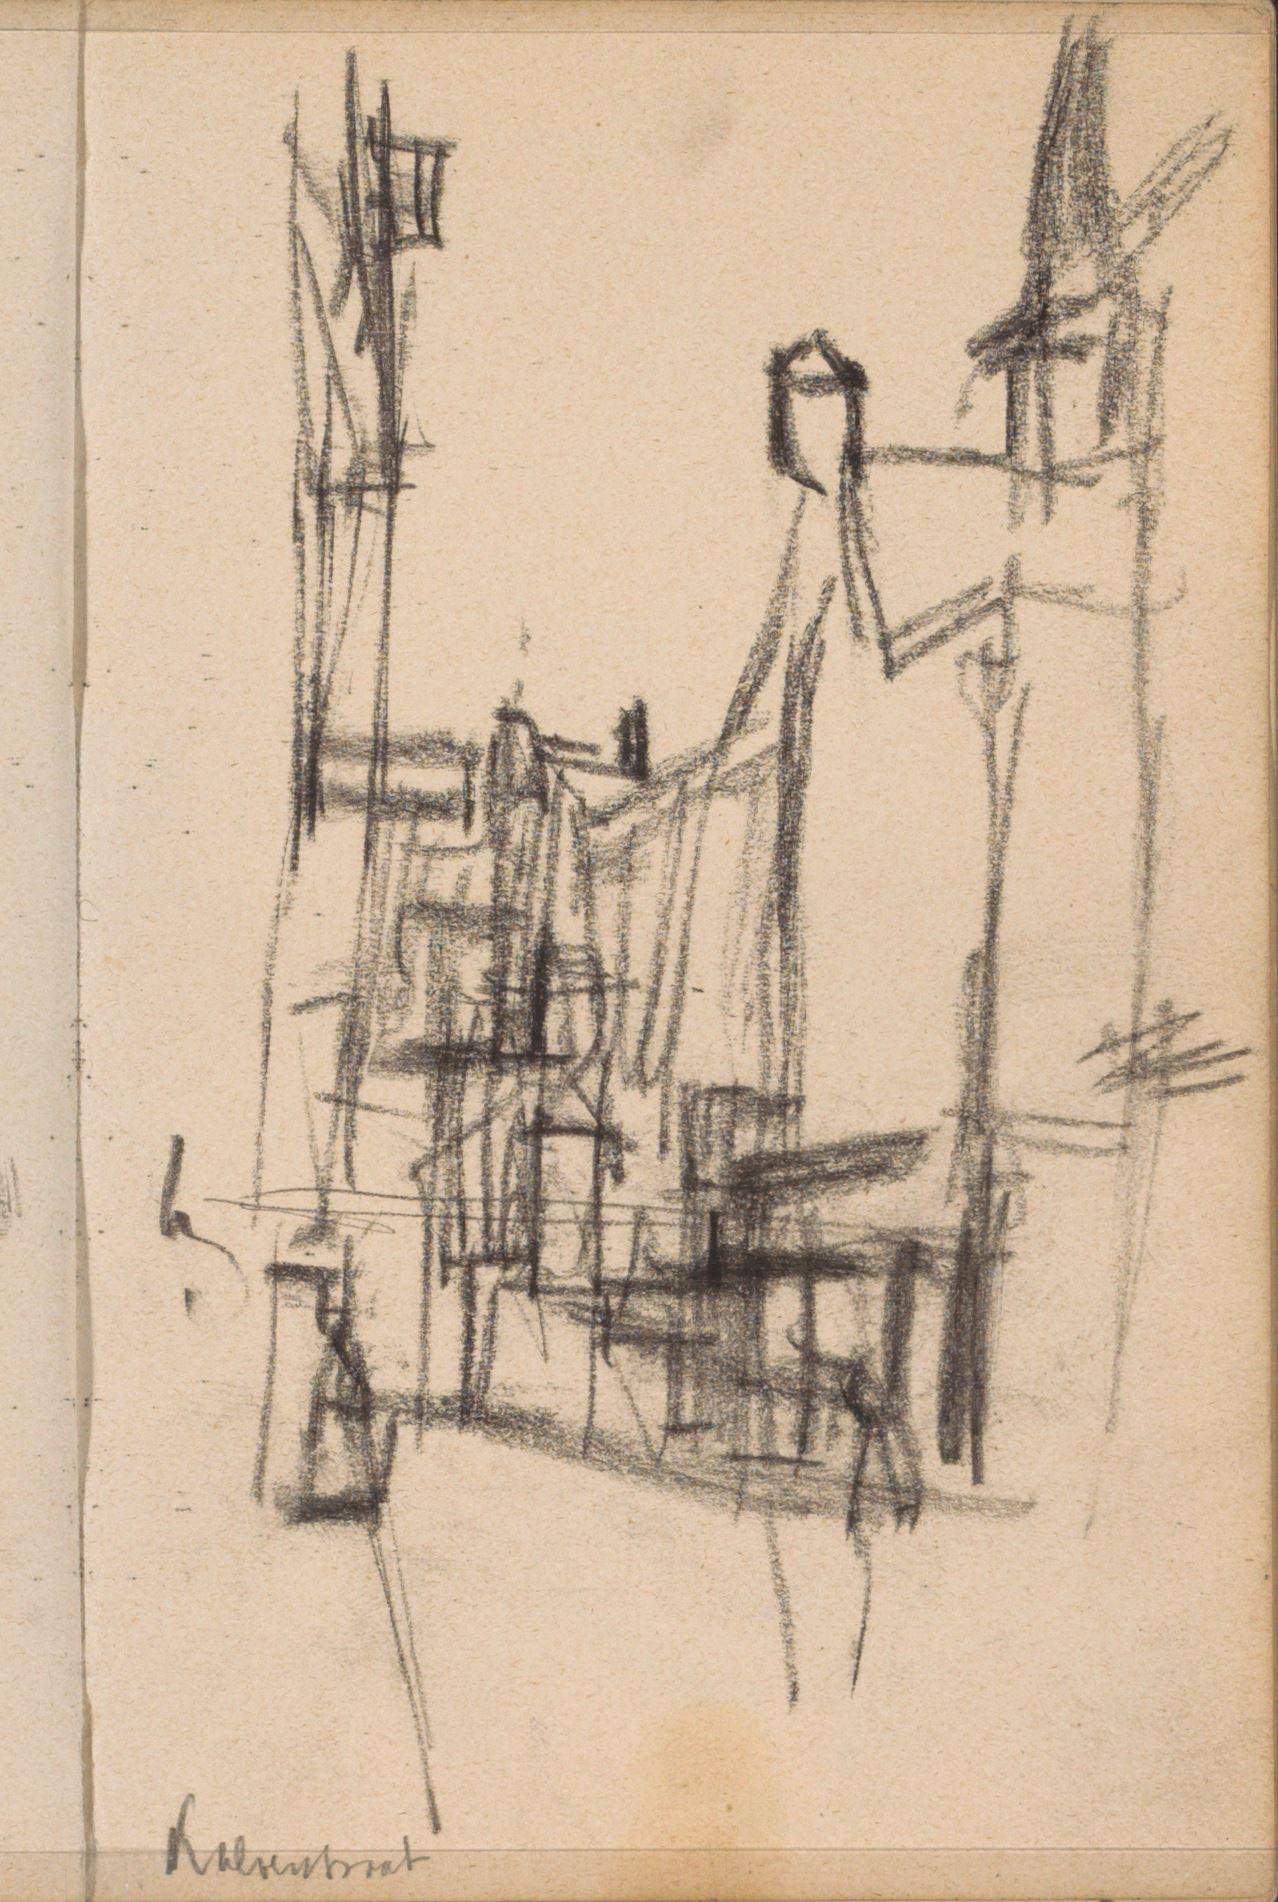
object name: sketchbook leaf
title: Gezicht op de Kalverstraat met de toren van de Nieuwezijds Kapel te Amsterdam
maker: george hendrik breitner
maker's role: draughtsman, painter, print maker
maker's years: 1857-1923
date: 1907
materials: chalk, paper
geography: amsterdam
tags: urban housing, parts of church exterior and annexes: tower - qq - small church, chapel, street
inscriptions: annotation: ‘Kalverstraat’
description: Gezicht op de Kalverstraat met de toren van de Nieuwezijds Kapel te Amsterdam. Pagina 24 uit een schetsboek met 46 bladen vervaardigd in Amsterdam, Rotterdam en Haarlem.